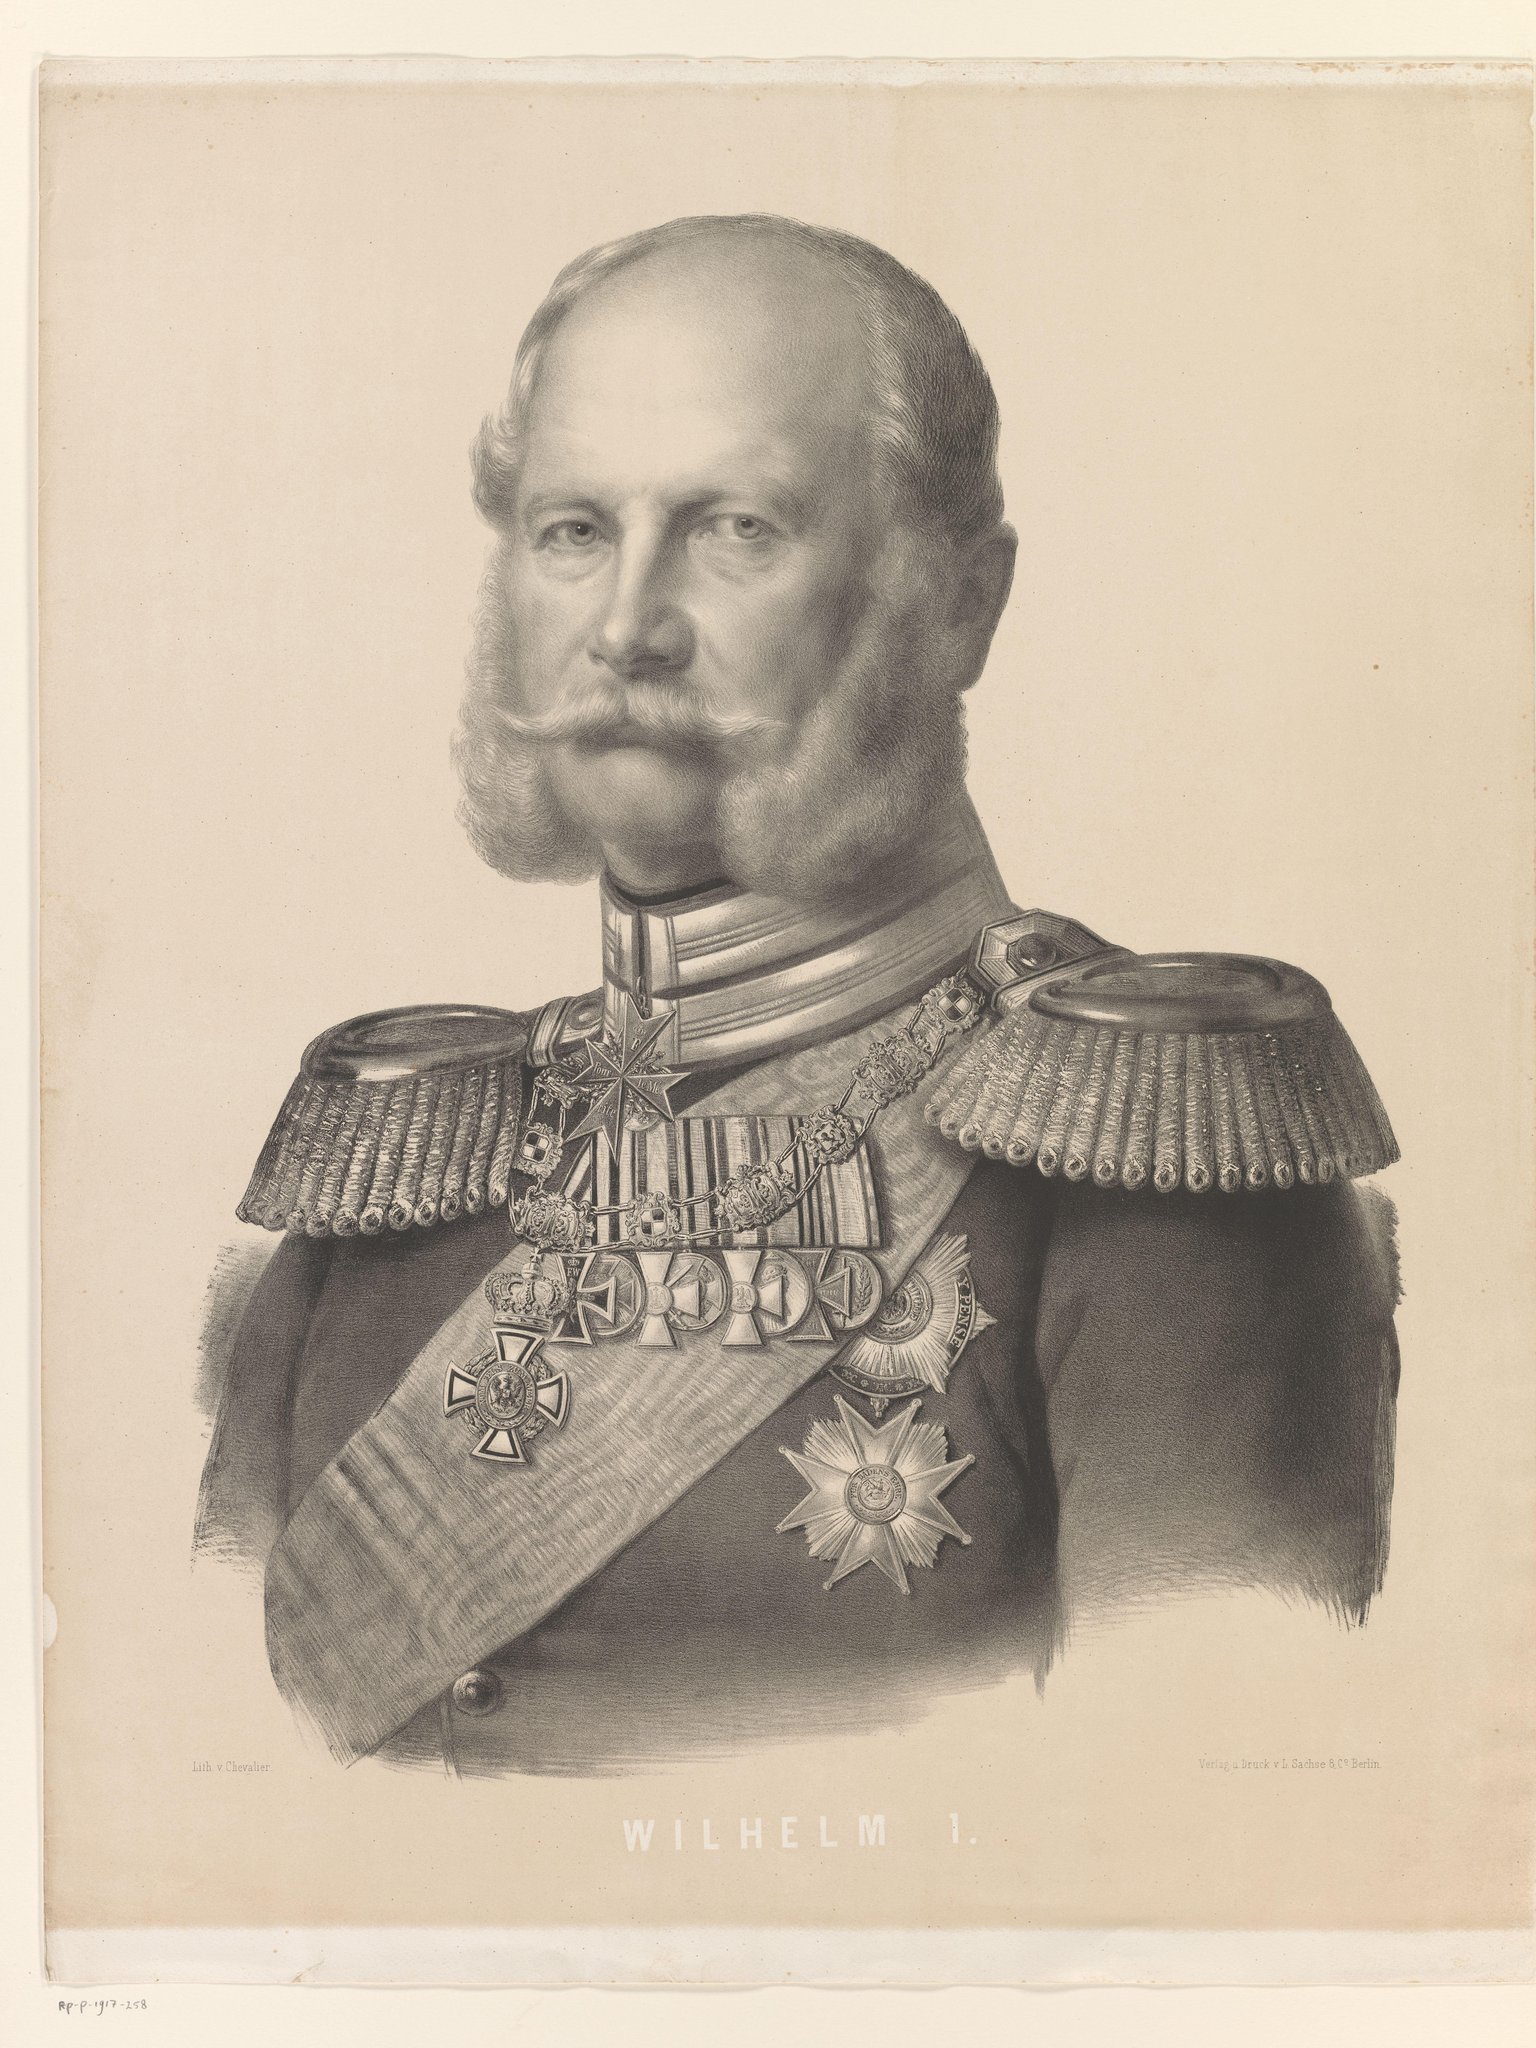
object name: print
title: Portret van Wilhelm I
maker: franz chevalier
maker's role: print maker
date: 1832-1854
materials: paper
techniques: tone lithography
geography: berlin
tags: berlin, wilhelm i (keizer van duitsland), moustache, adult man, historical persons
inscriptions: collector's mark: Lugt 2228